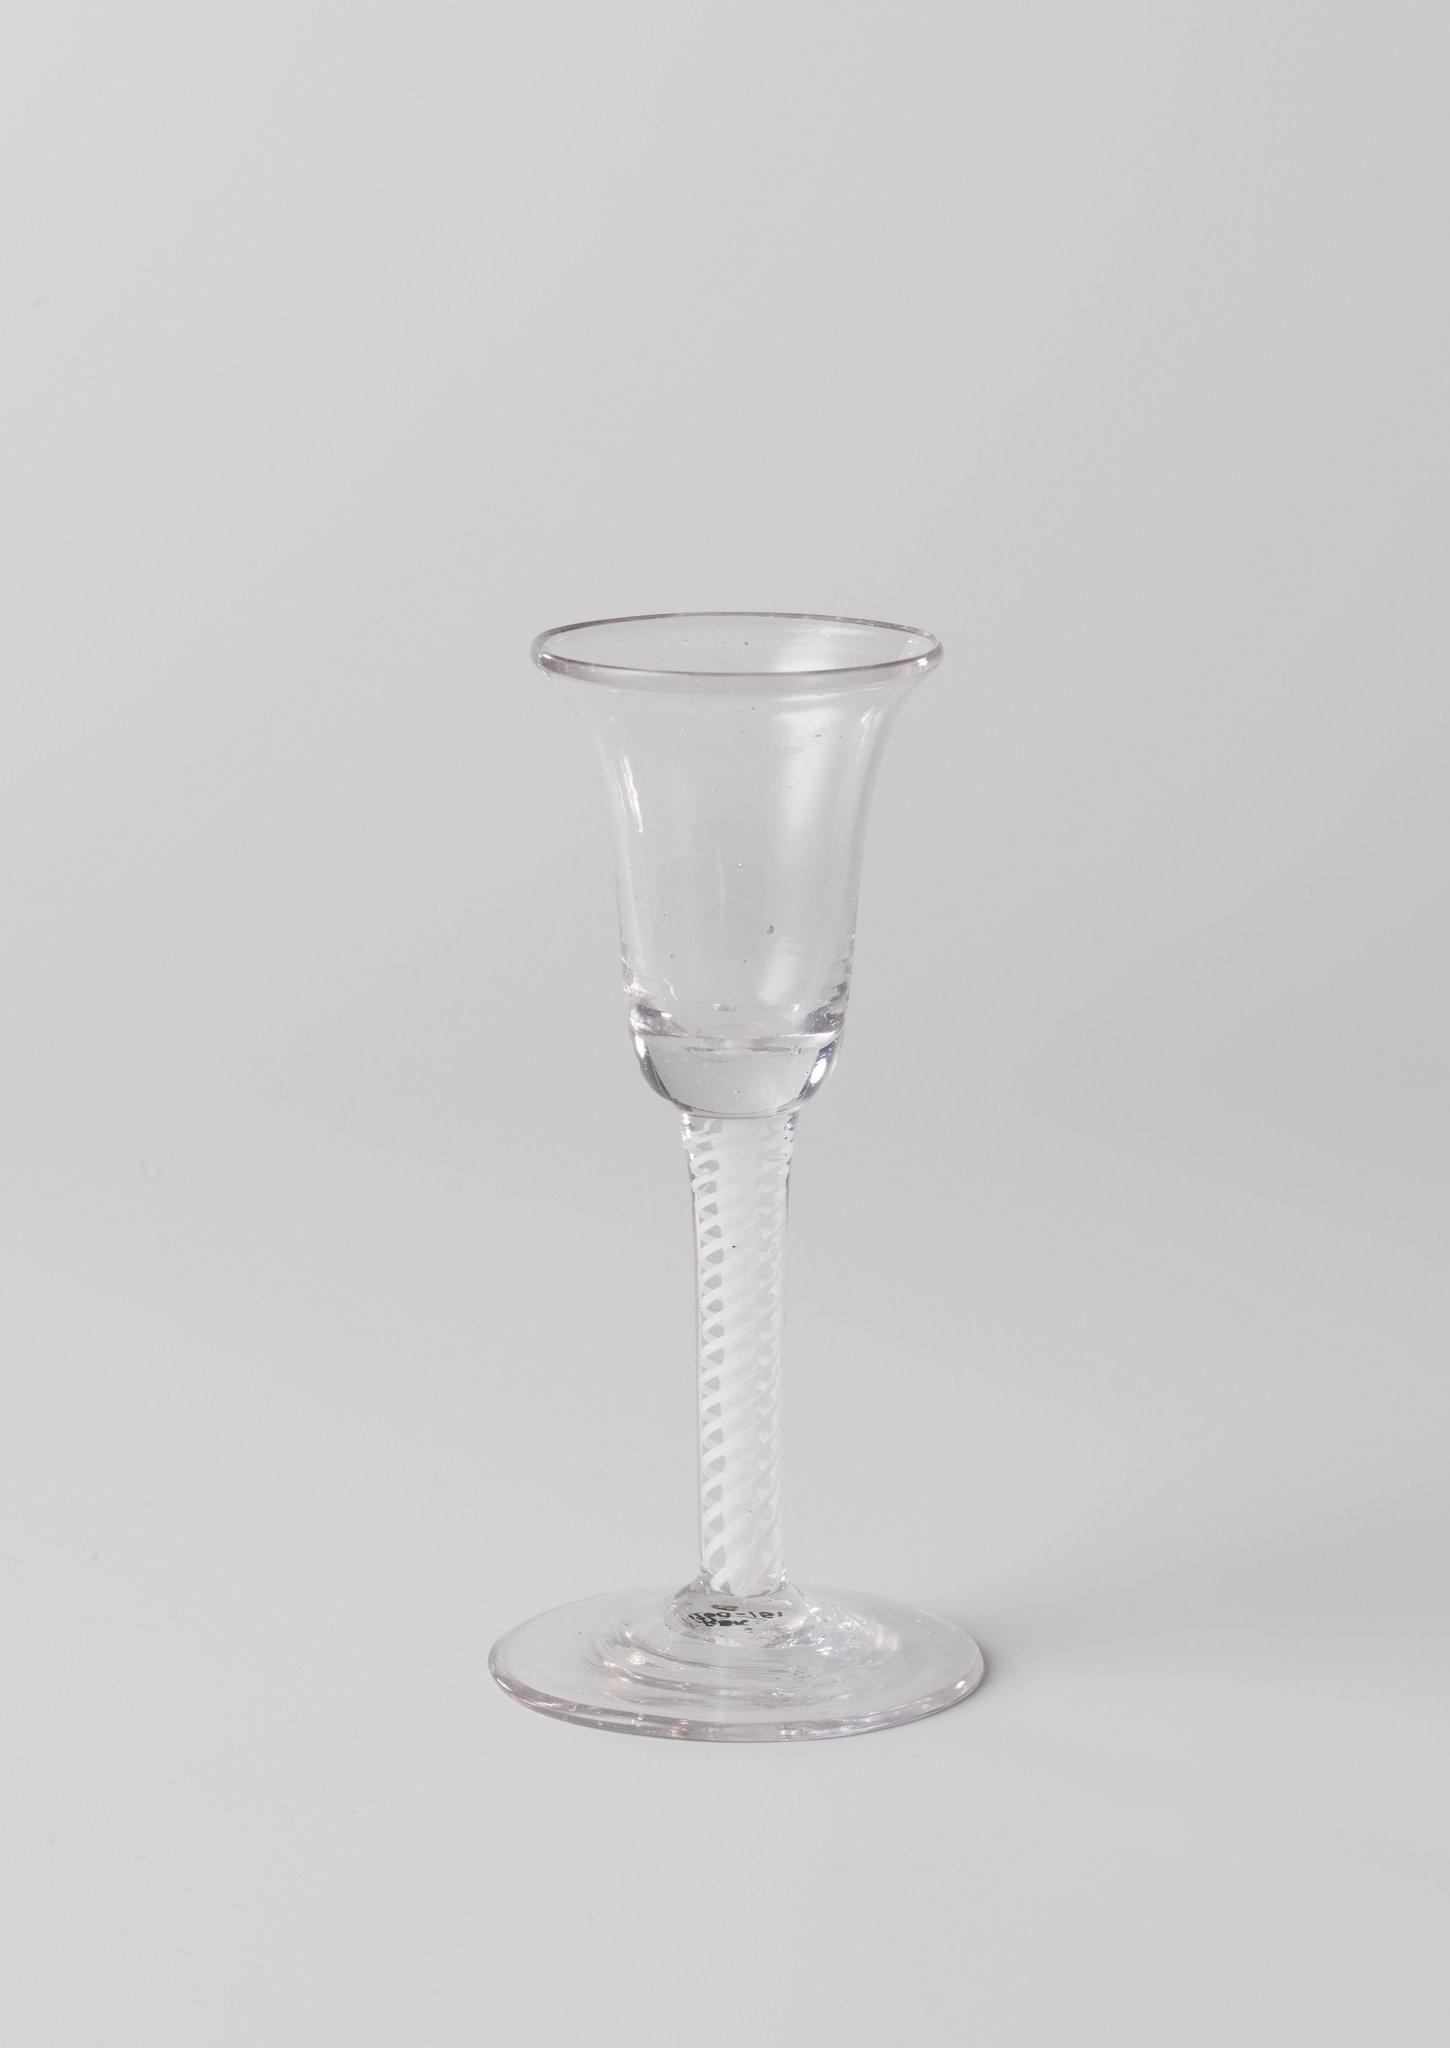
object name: goblet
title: Slingerglas met klokvormige kelk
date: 1750-1775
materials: glass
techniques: glassblowing, vetro a retorti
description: Slingerglas met platte voet en rechte stam. In de stam opaak witte slingers rond witte netwerkspiraal. Klokvormige kelk